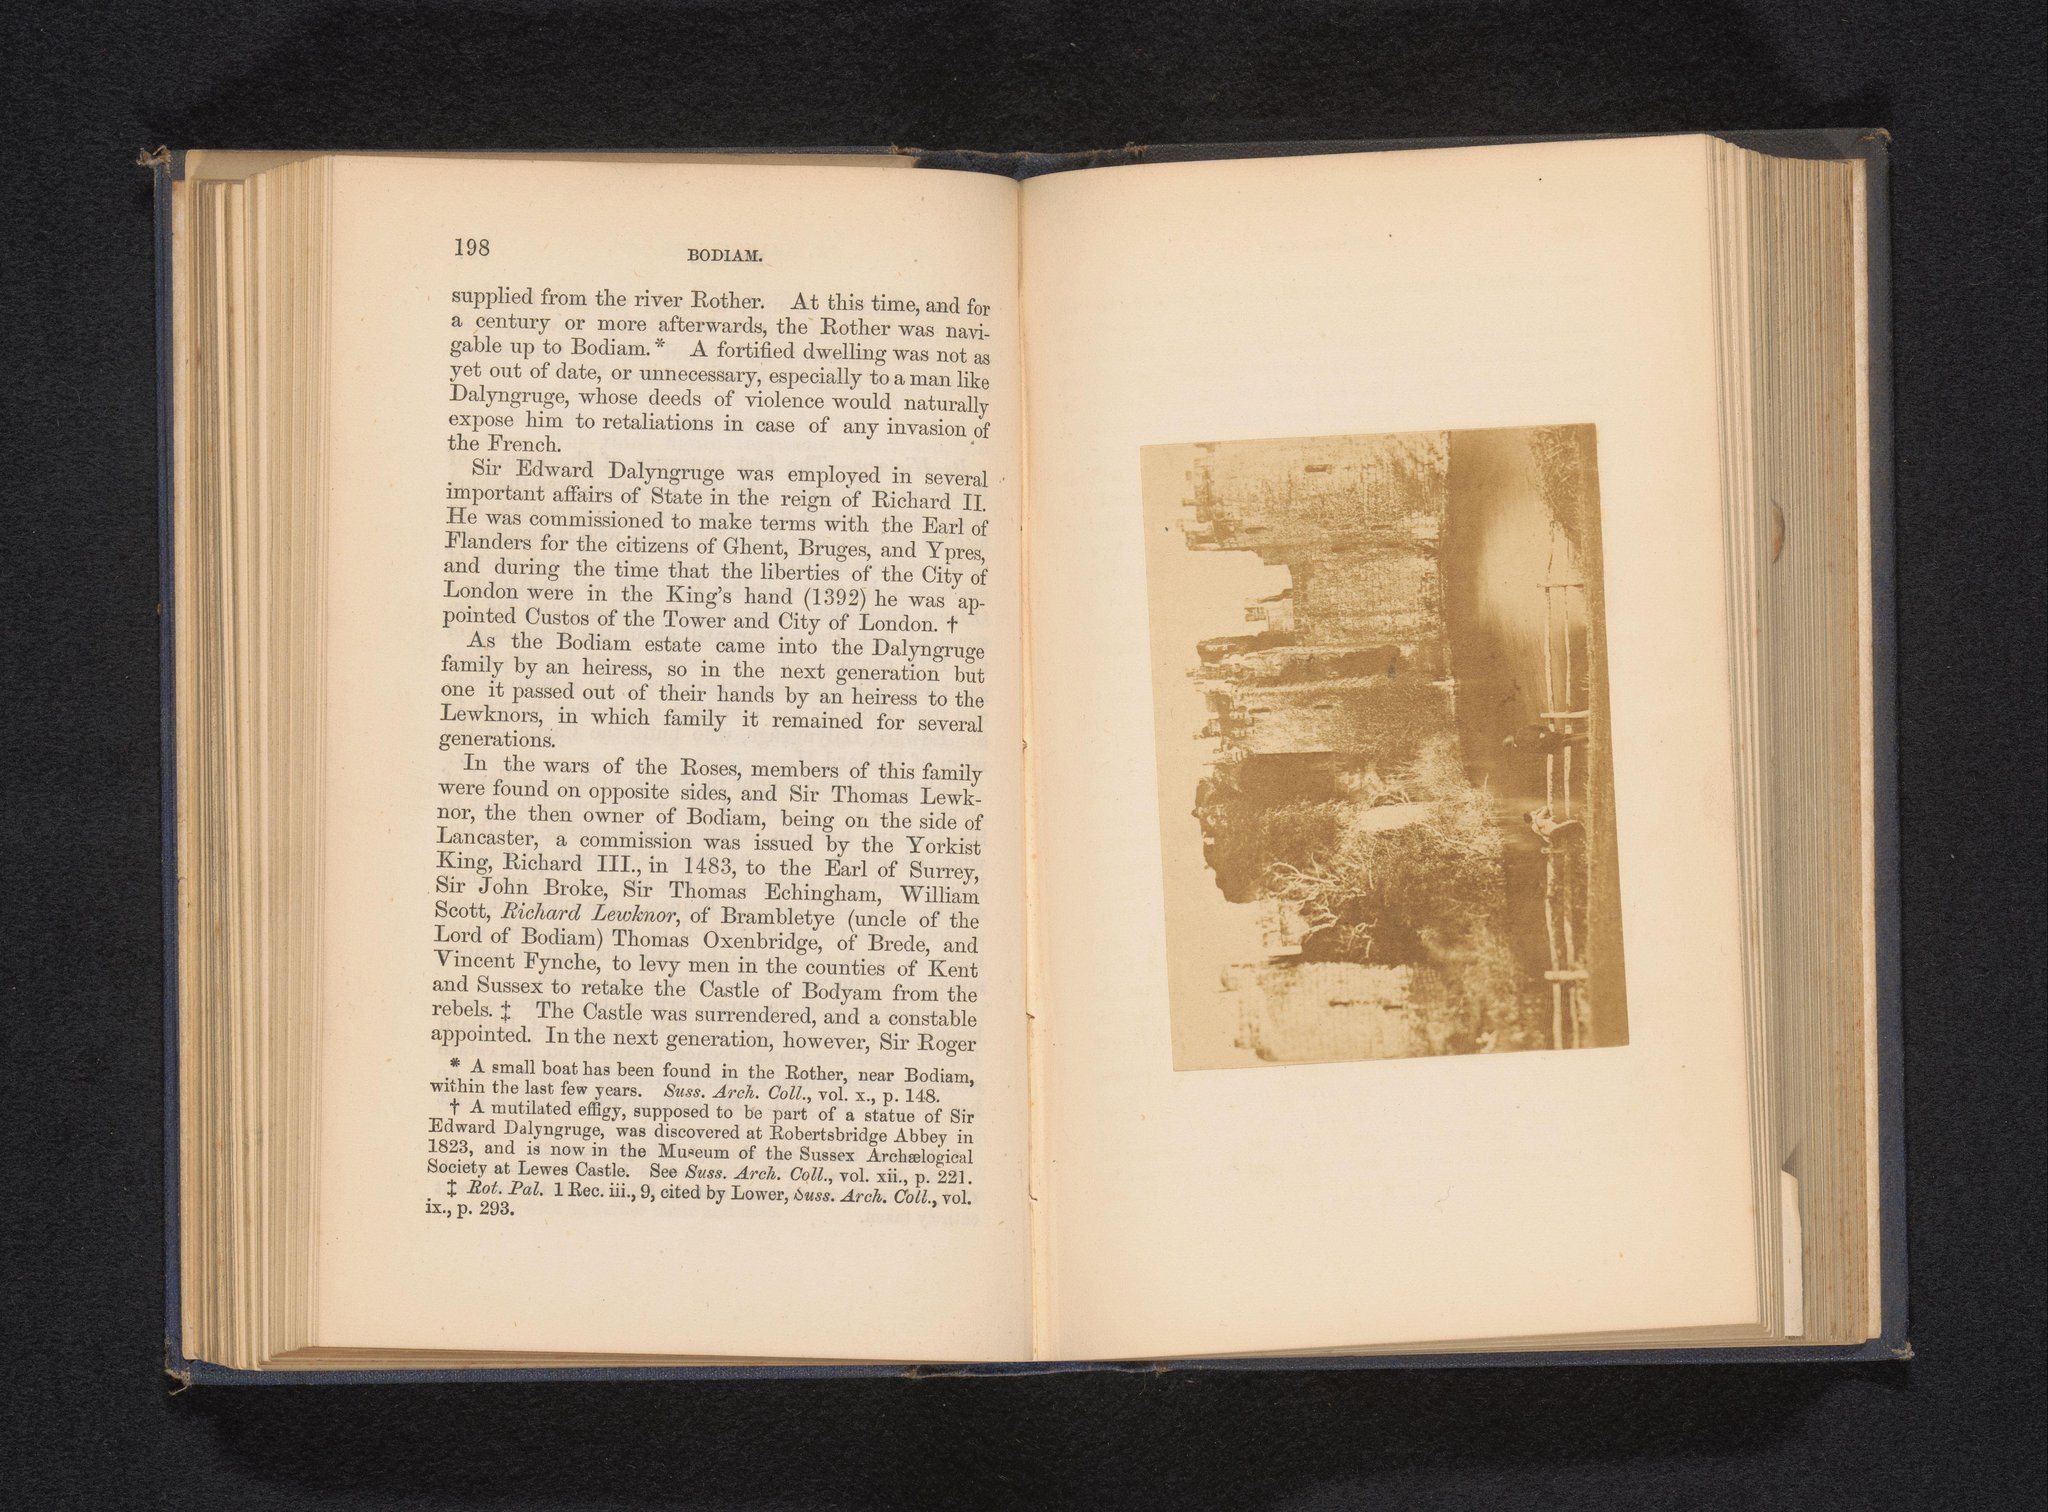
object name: page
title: Gezicht op Bodiam Castle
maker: Anonymous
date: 1859-1864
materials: photographic support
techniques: albumen print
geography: bodiam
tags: castle